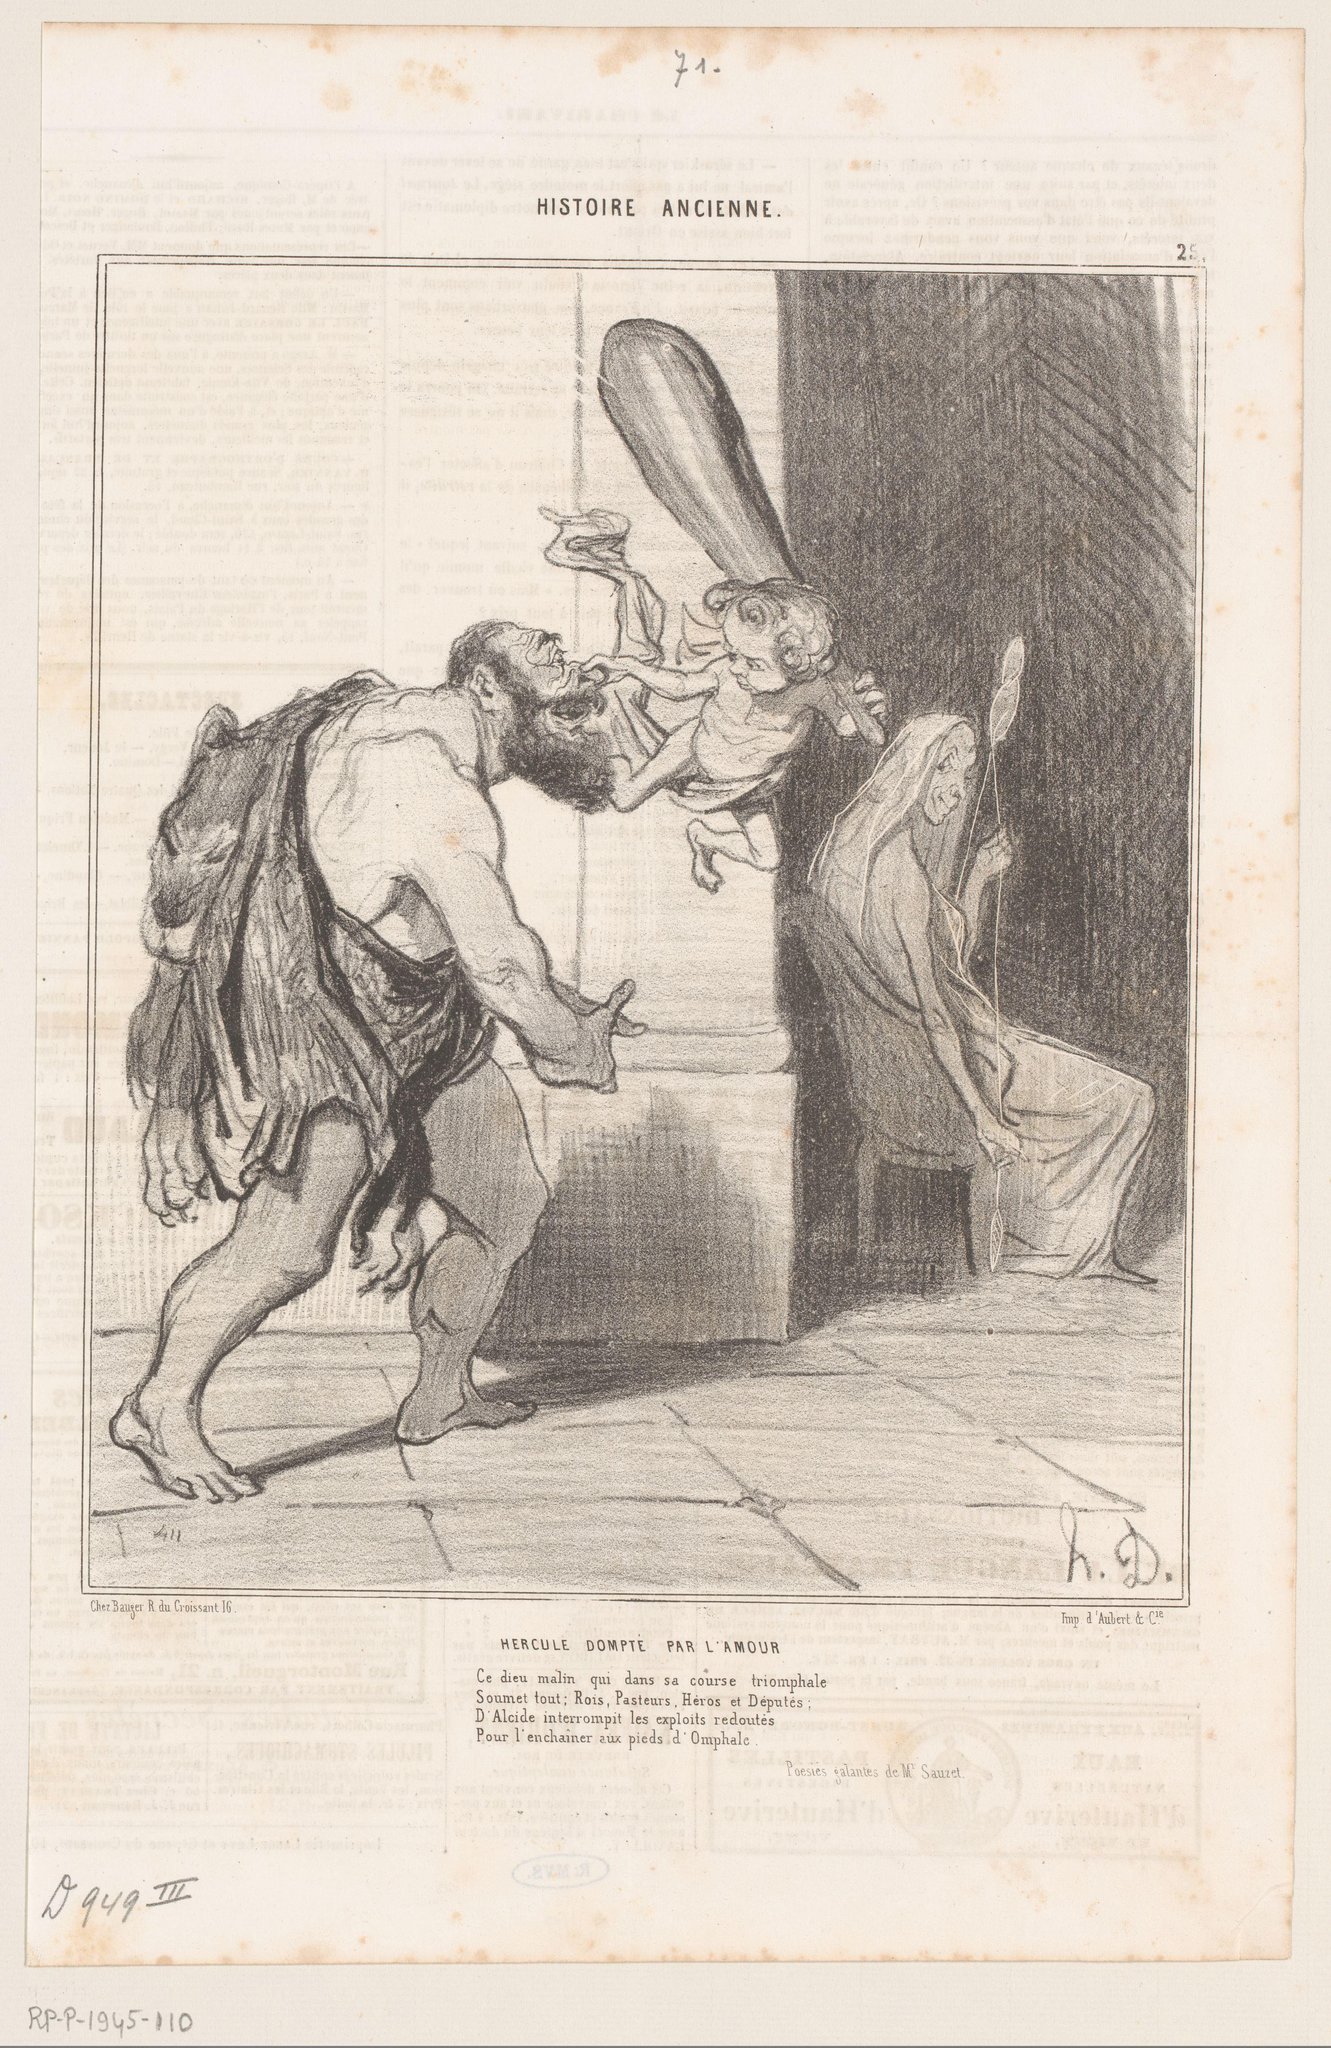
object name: cartoon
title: Karikatuur van Hercules en Omphale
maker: honoré daumier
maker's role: draughtsman, painter, print maker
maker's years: 1808-1879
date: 1842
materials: paper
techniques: lithograph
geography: paris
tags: hercules in love with omphale; the hero is set to spin wool or to do other women's work among the servants, while omphale wears his lion's skin and wields his club and bow, caricatures (human types)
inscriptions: collector's mark: Lugt 2228a, number: ‘71’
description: Prent gepubliceerd in: Le Charivari, Aubert: Parijs, 18-09-1842. Le Charivari was een humoristische krant met karikaturen en (politieke) cartoons.